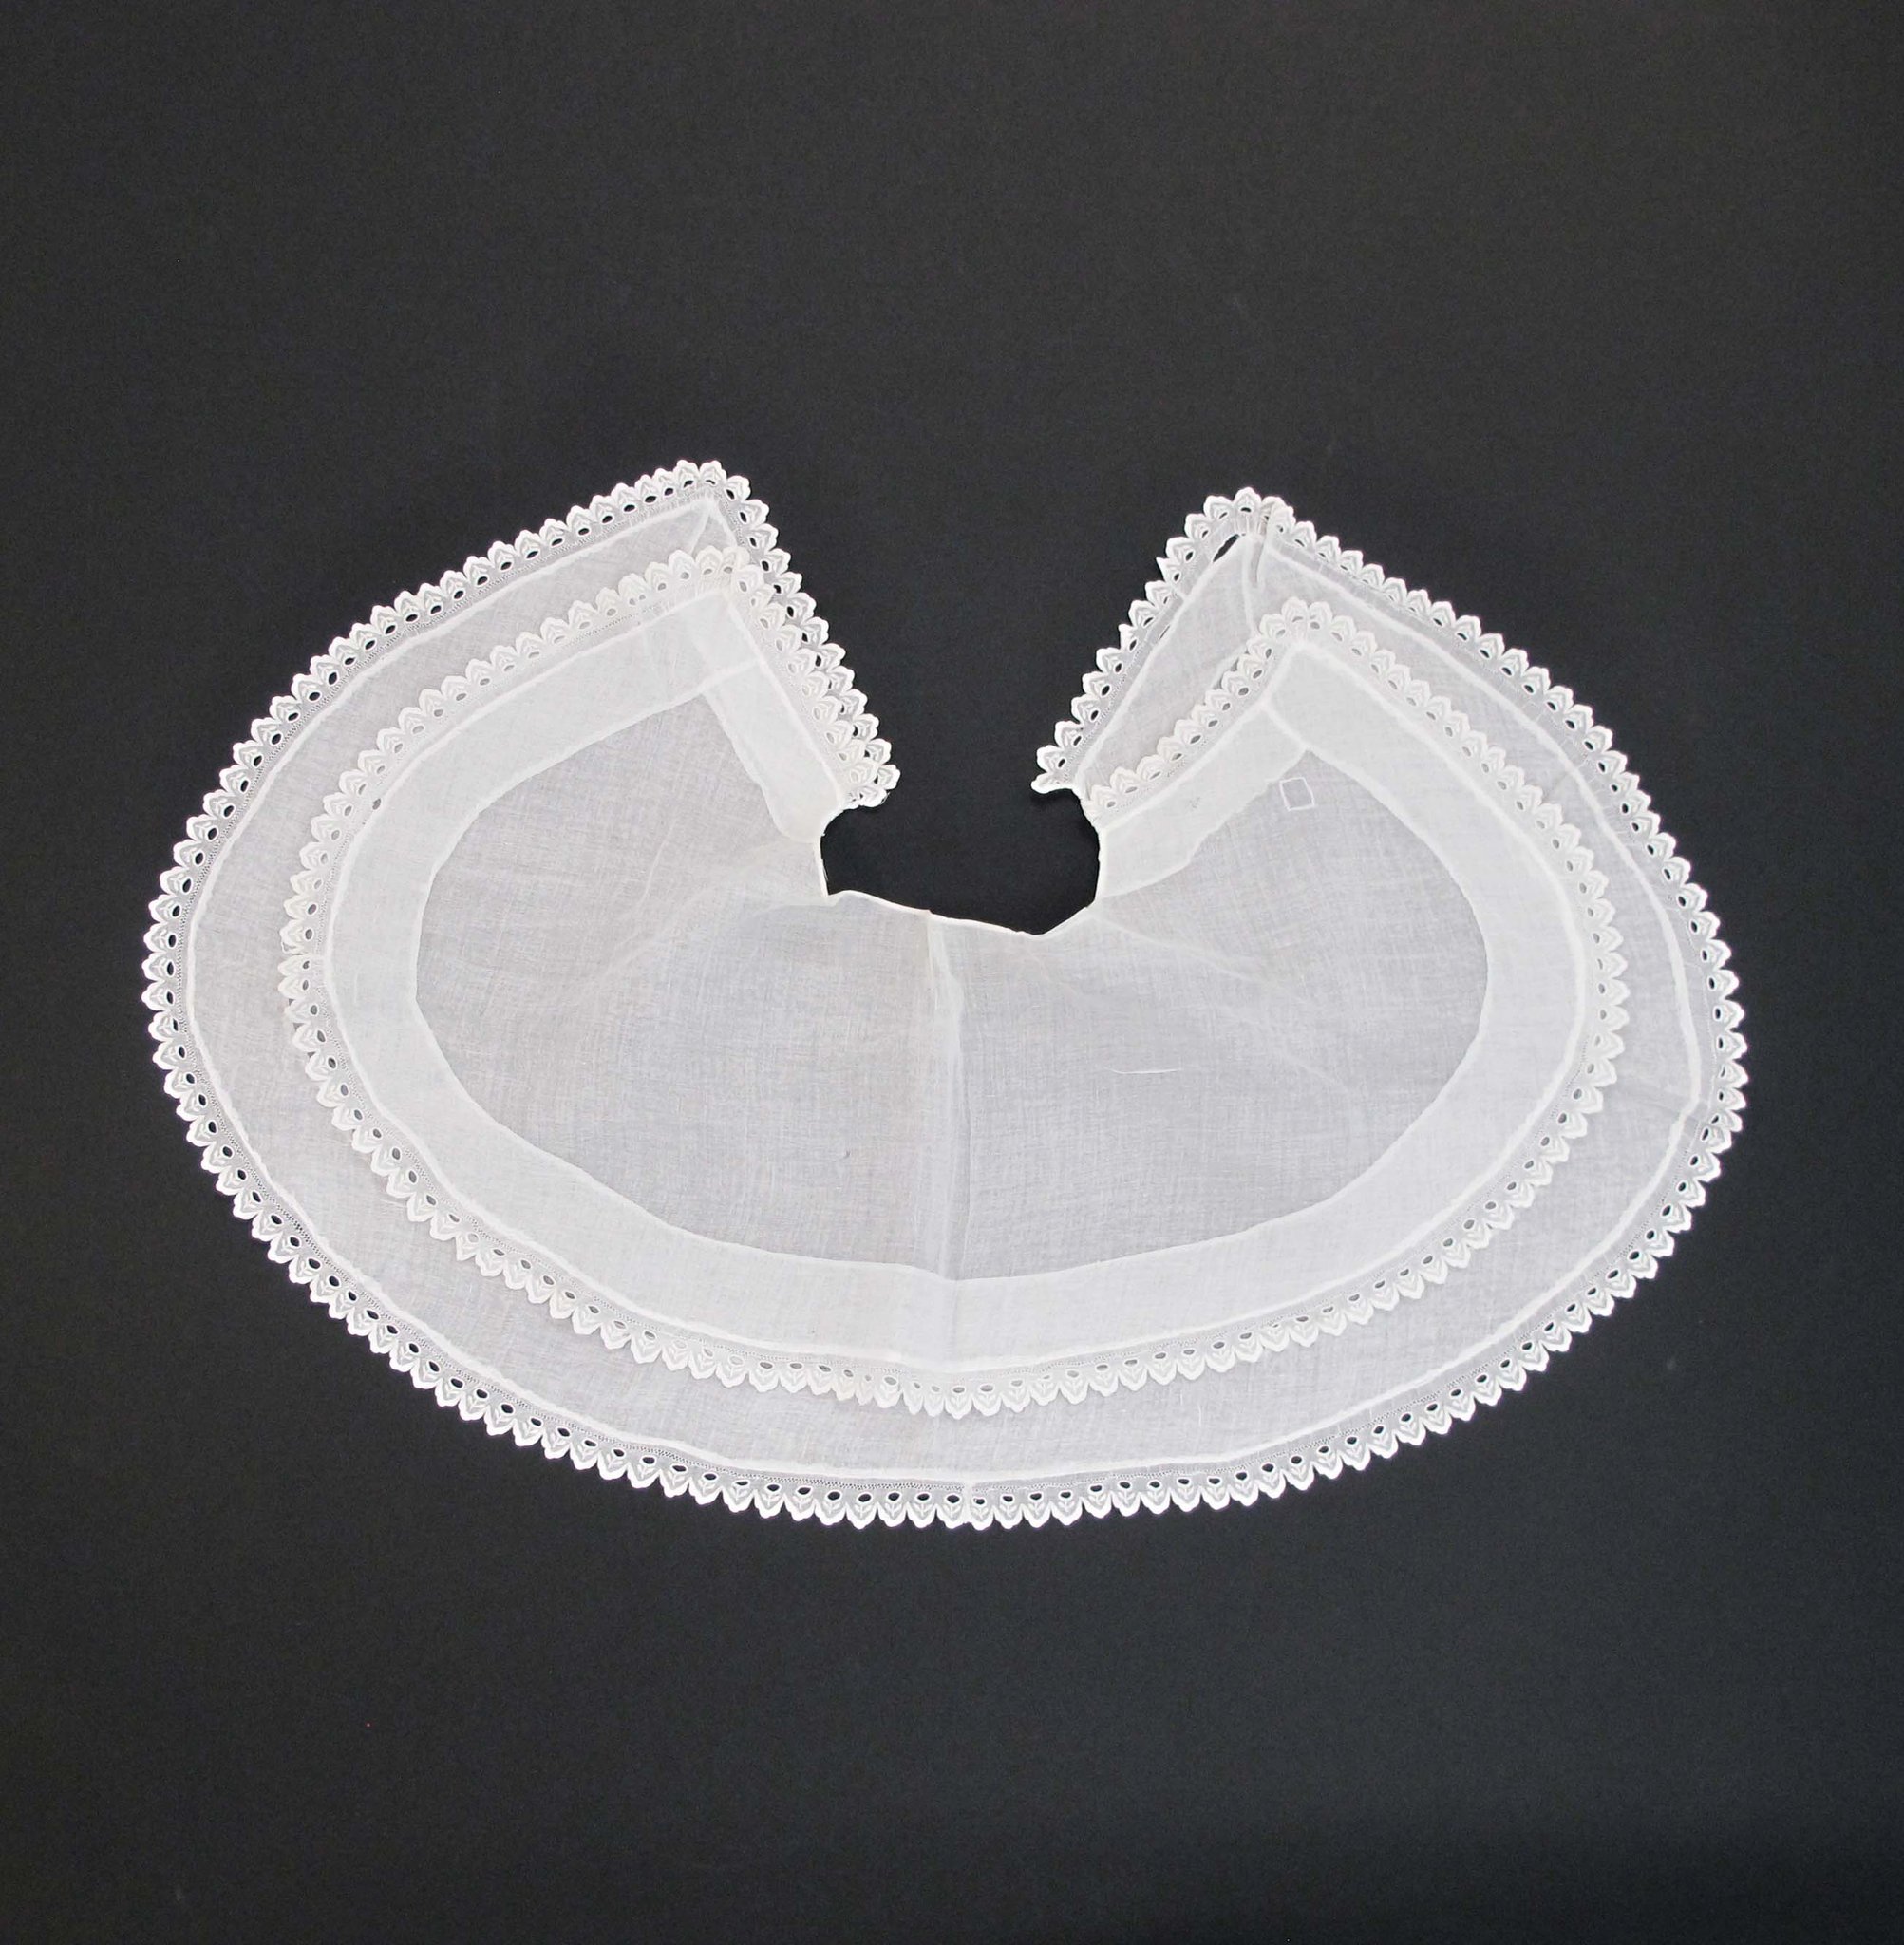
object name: pelerine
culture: french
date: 1825-1835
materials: cotton